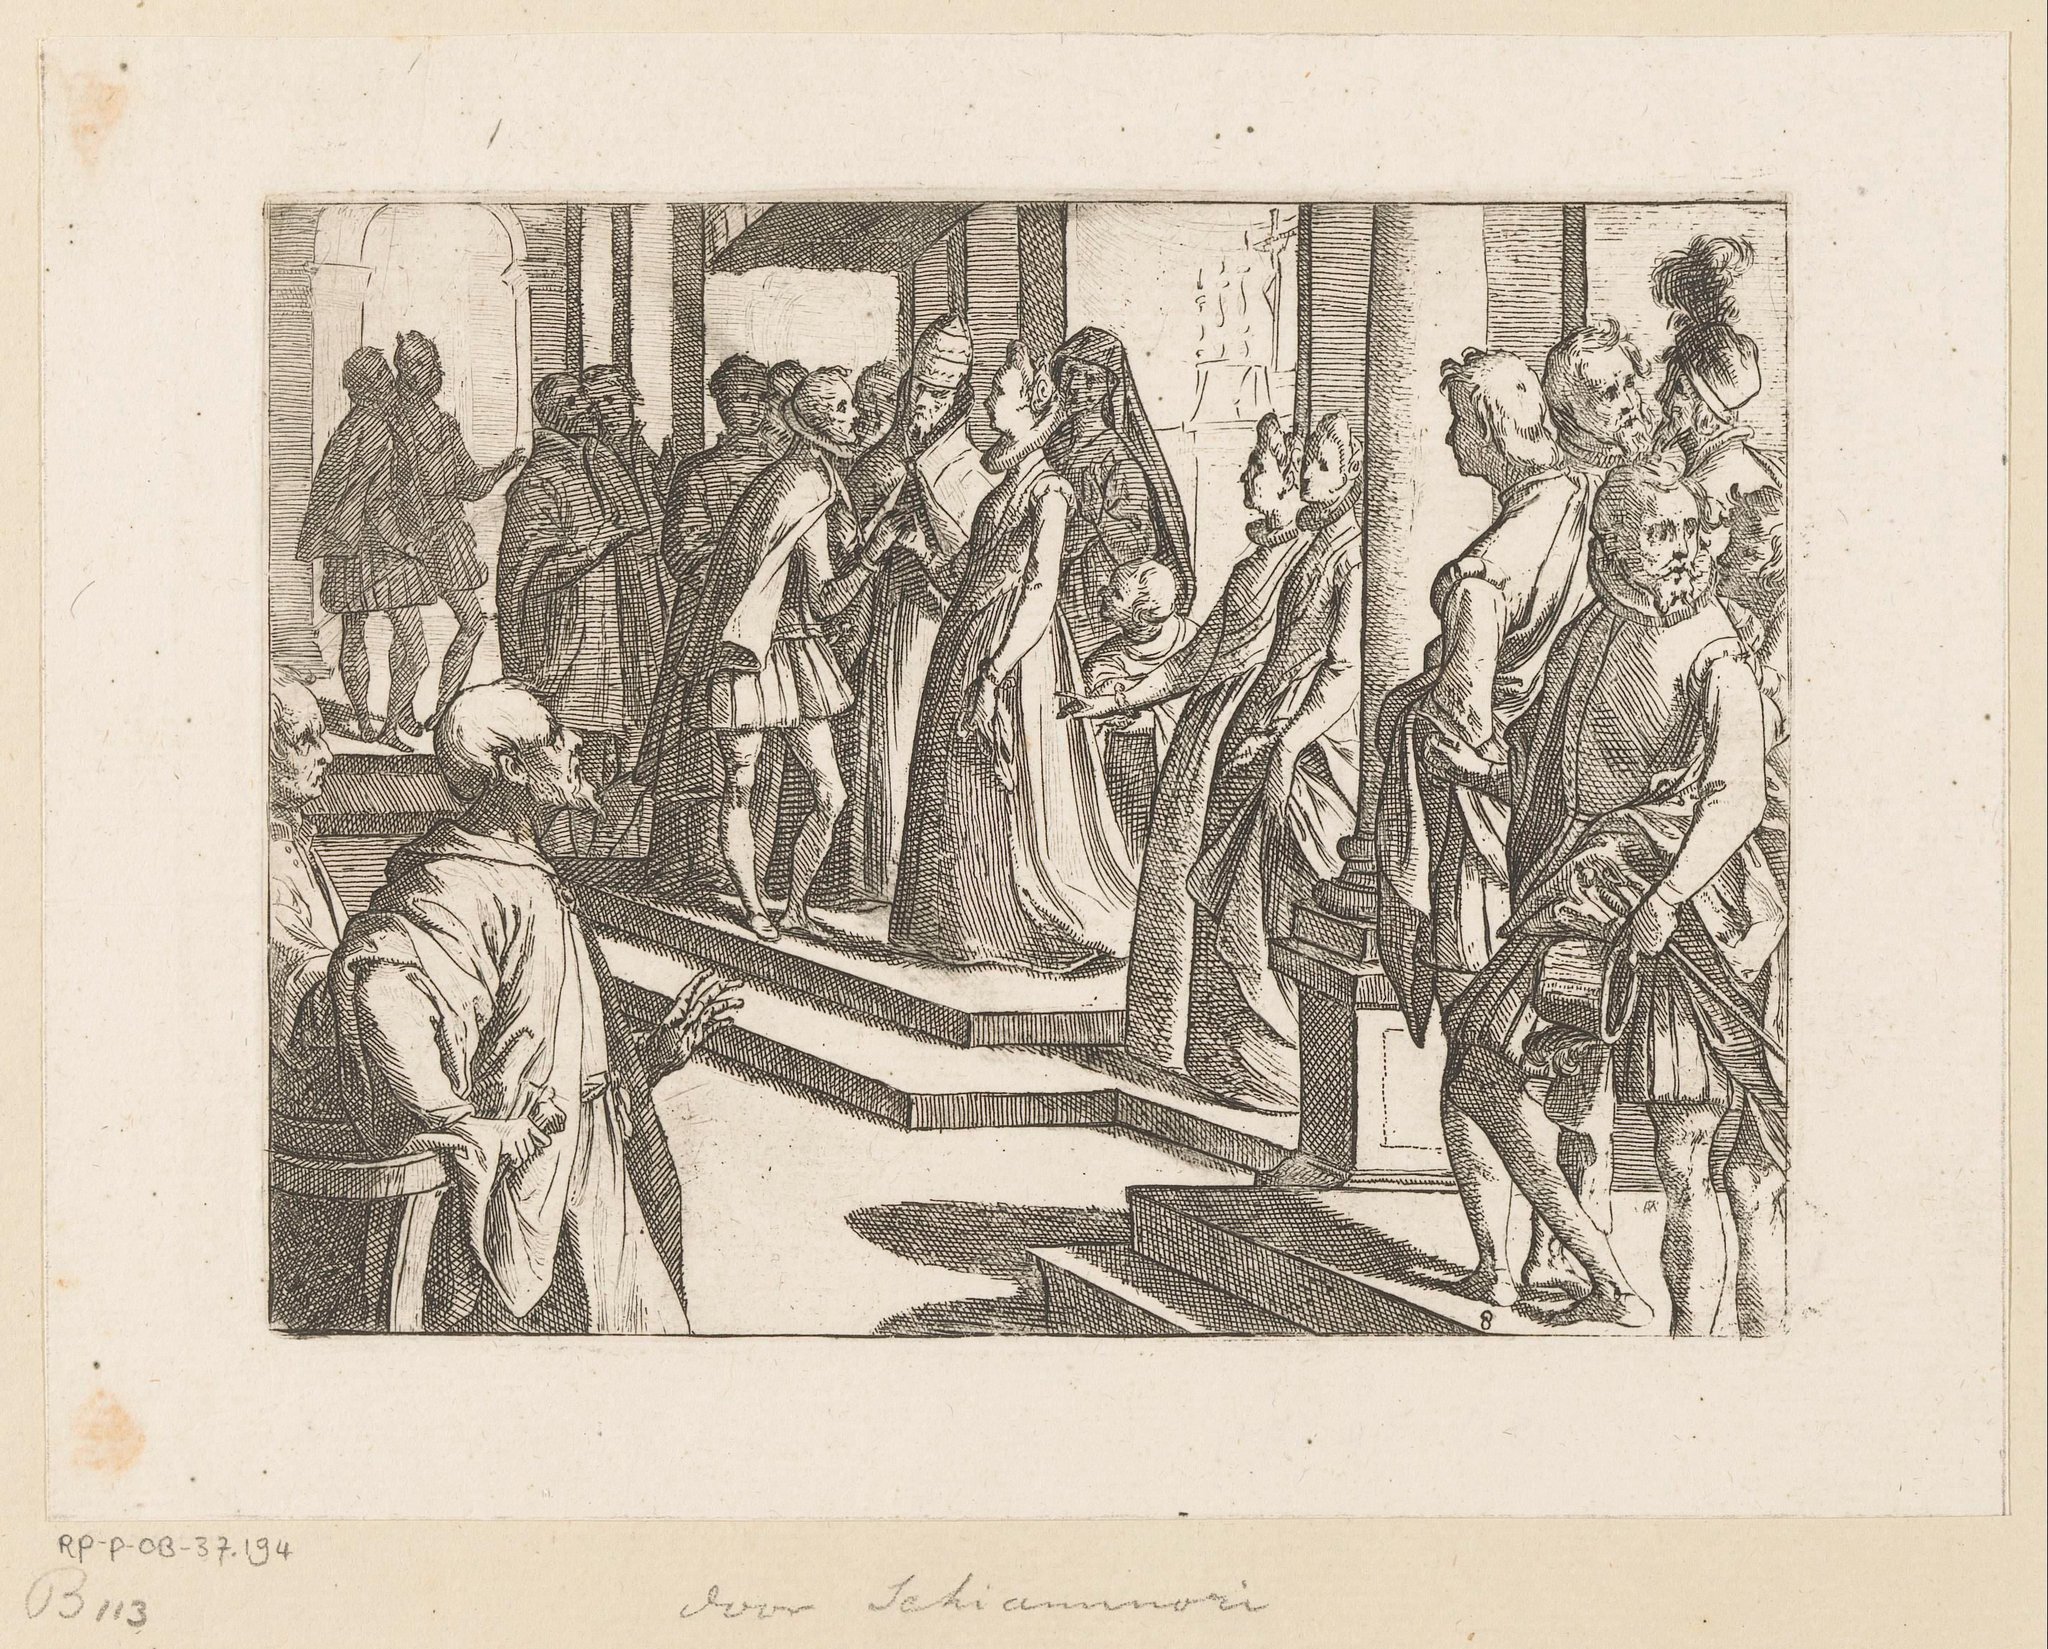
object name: print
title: Essequie della sacra cattolica e real maesta di Margherita d'Austria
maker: raffaello schiaminossi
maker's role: painter, print maker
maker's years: 1572-1622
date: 1612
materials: paper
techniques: etching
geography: italy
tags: filips iii (koning van spanje), brussels, betrothal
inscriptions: collector's mark: Lugt 240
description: Deze prent maakt deel uit van een serie met voorstellingen uit het leven van Margaretha van Oostenrijk. De serie bestaat uit 26 prenten waarvan er 5 aanwezig zijn in de collectie van het Rijksmuseum. De serie bevat prenten door Raffaello Schiaminossi, Antonio Tempesta en Jacques Callot. Deze prent is gebruikt voor: Altoviti, Giovanni. Essequie della sacra cattolica e real maesta di Margherita d'Austria. Florence: Bartolomeo Sermatelli e fratelli, 1612, p. 19.